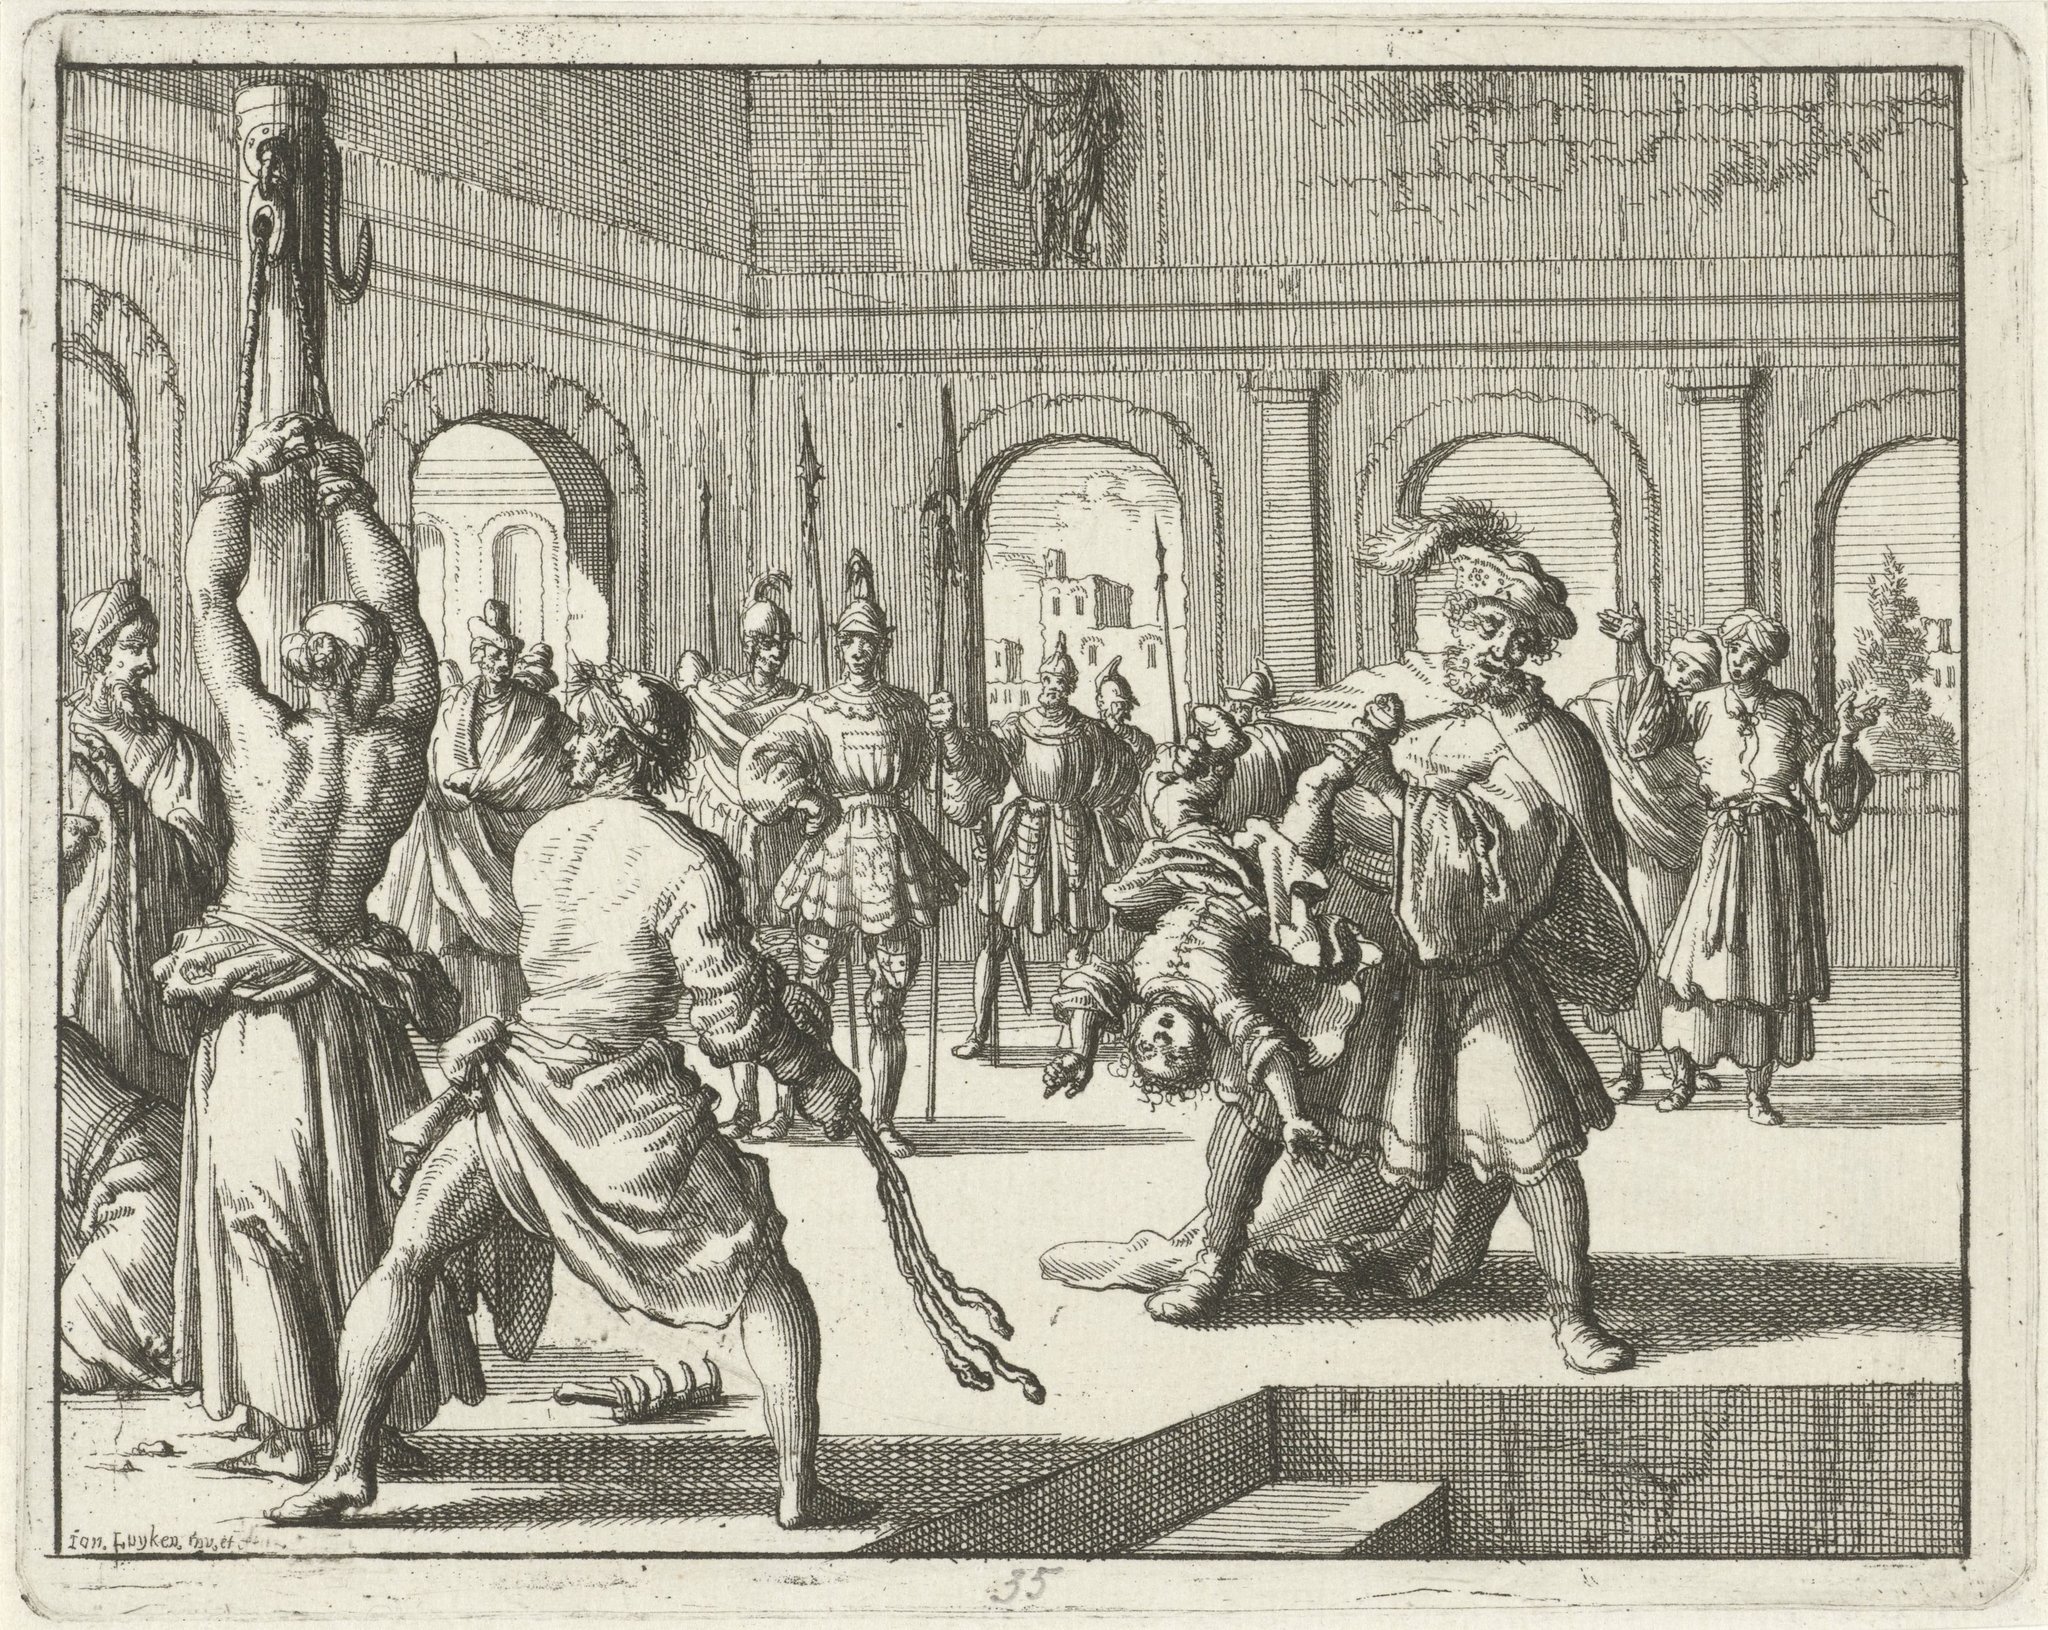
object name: print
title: Julitta van Iconië gegeseld terwijl haar kind wordt gedood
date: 1685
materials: paper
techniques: etching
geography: amsterdam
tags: male saints (with name), flogging, scourging (in public), murder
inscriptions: collector's mark: Lugt 2228, number: ‘35’